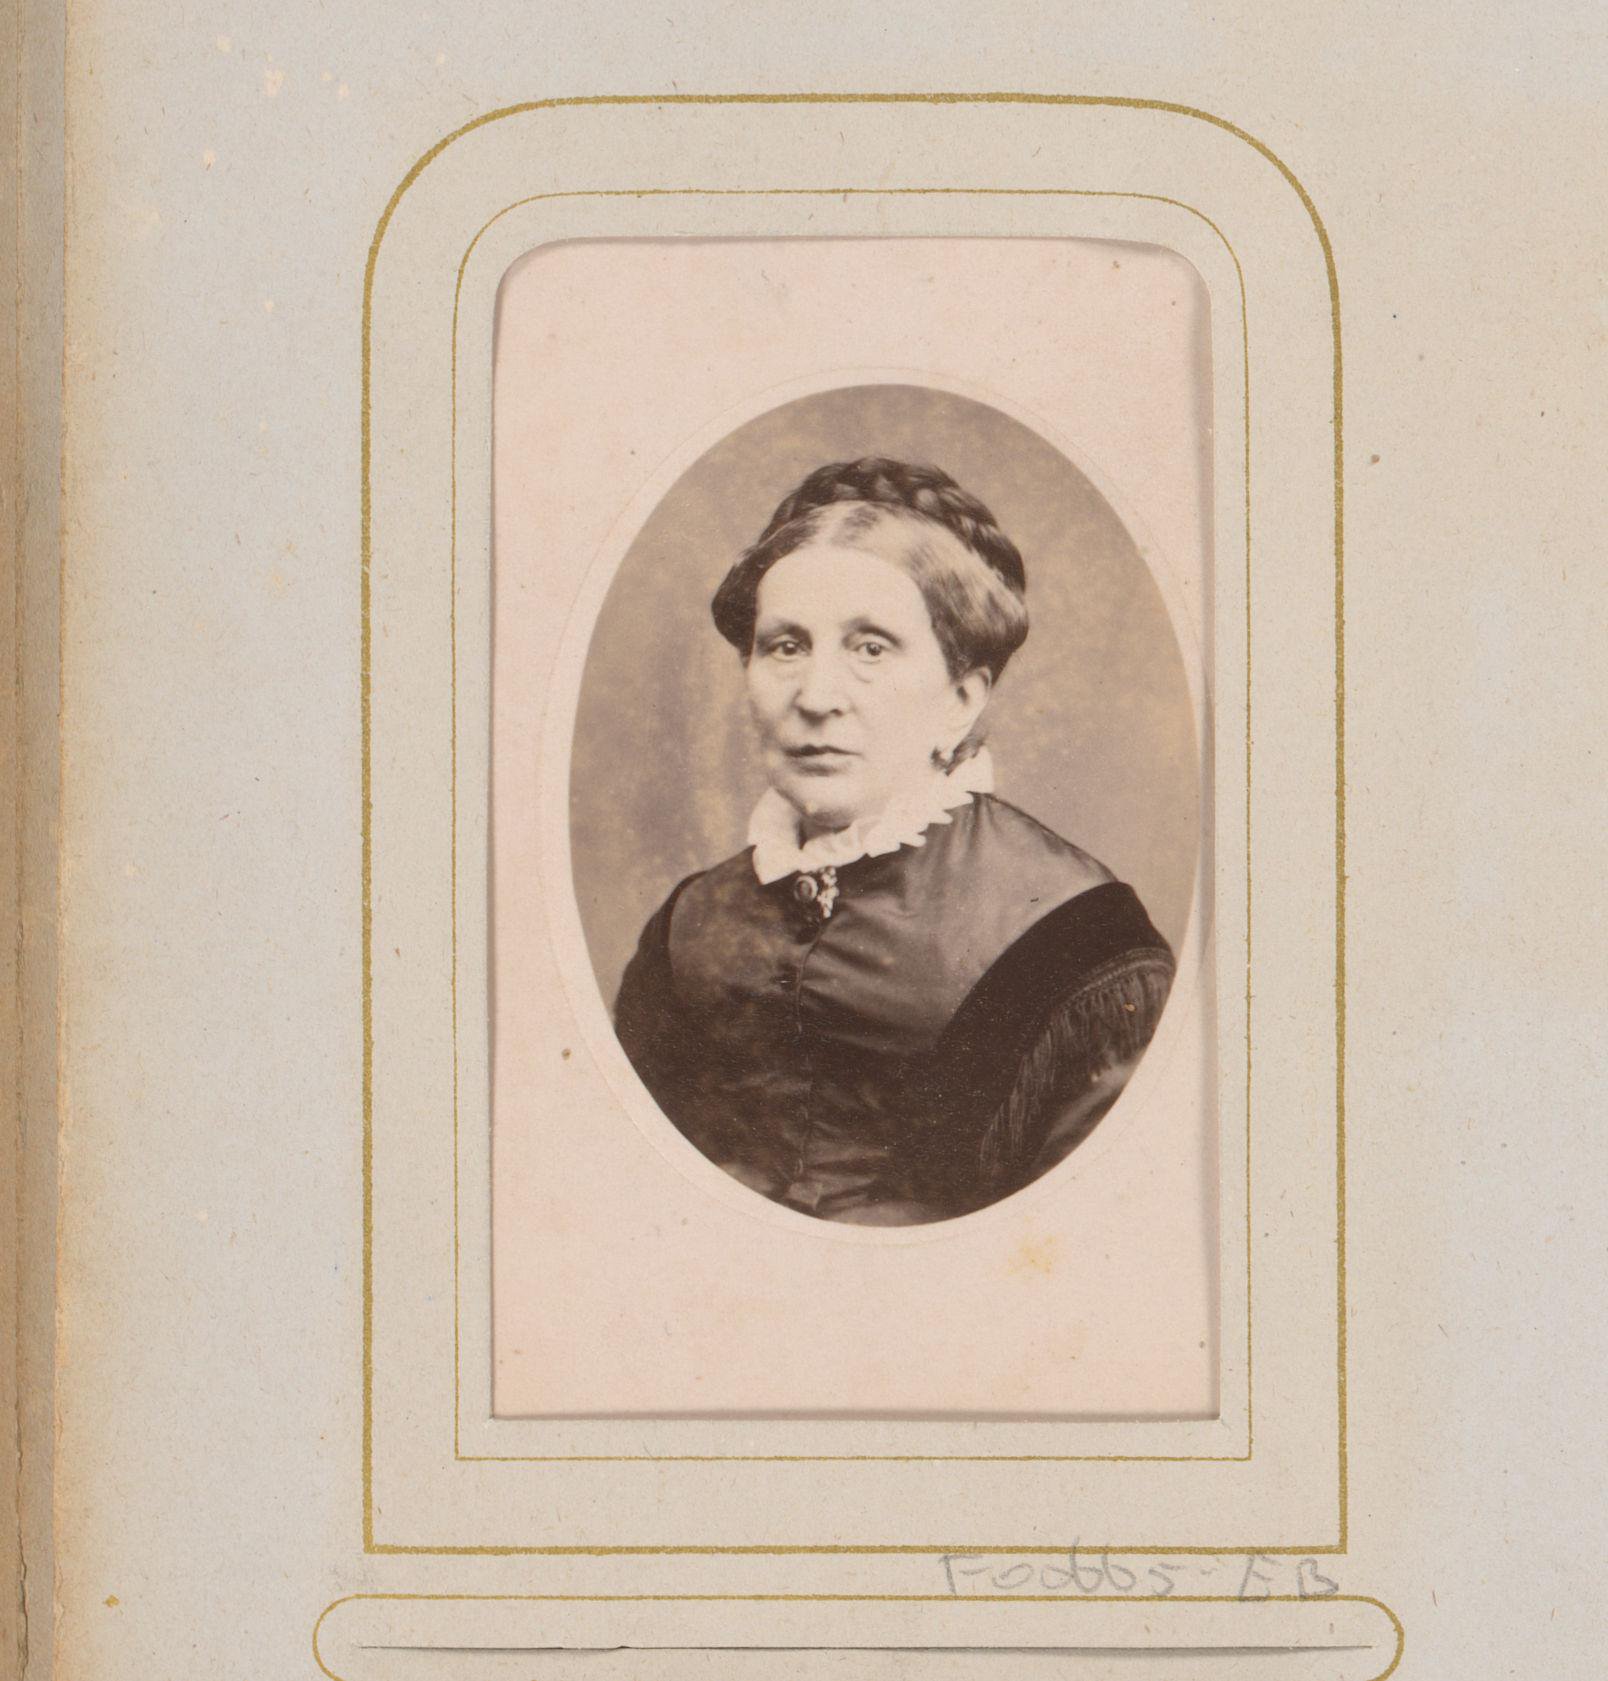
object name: carte de visite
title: Portret van een vrouw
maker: hendrik anthonie karel ringler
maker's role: draughtsman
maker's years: 1846-1879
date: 1872-1879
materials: cardboard, photographic support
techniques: albumen print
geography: leeuwarden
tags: historical persons - bb - woman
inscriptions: inscription: ‘H.A.K. Ringler/ Weststraat bij het Zaailand/ Leeuwarden’